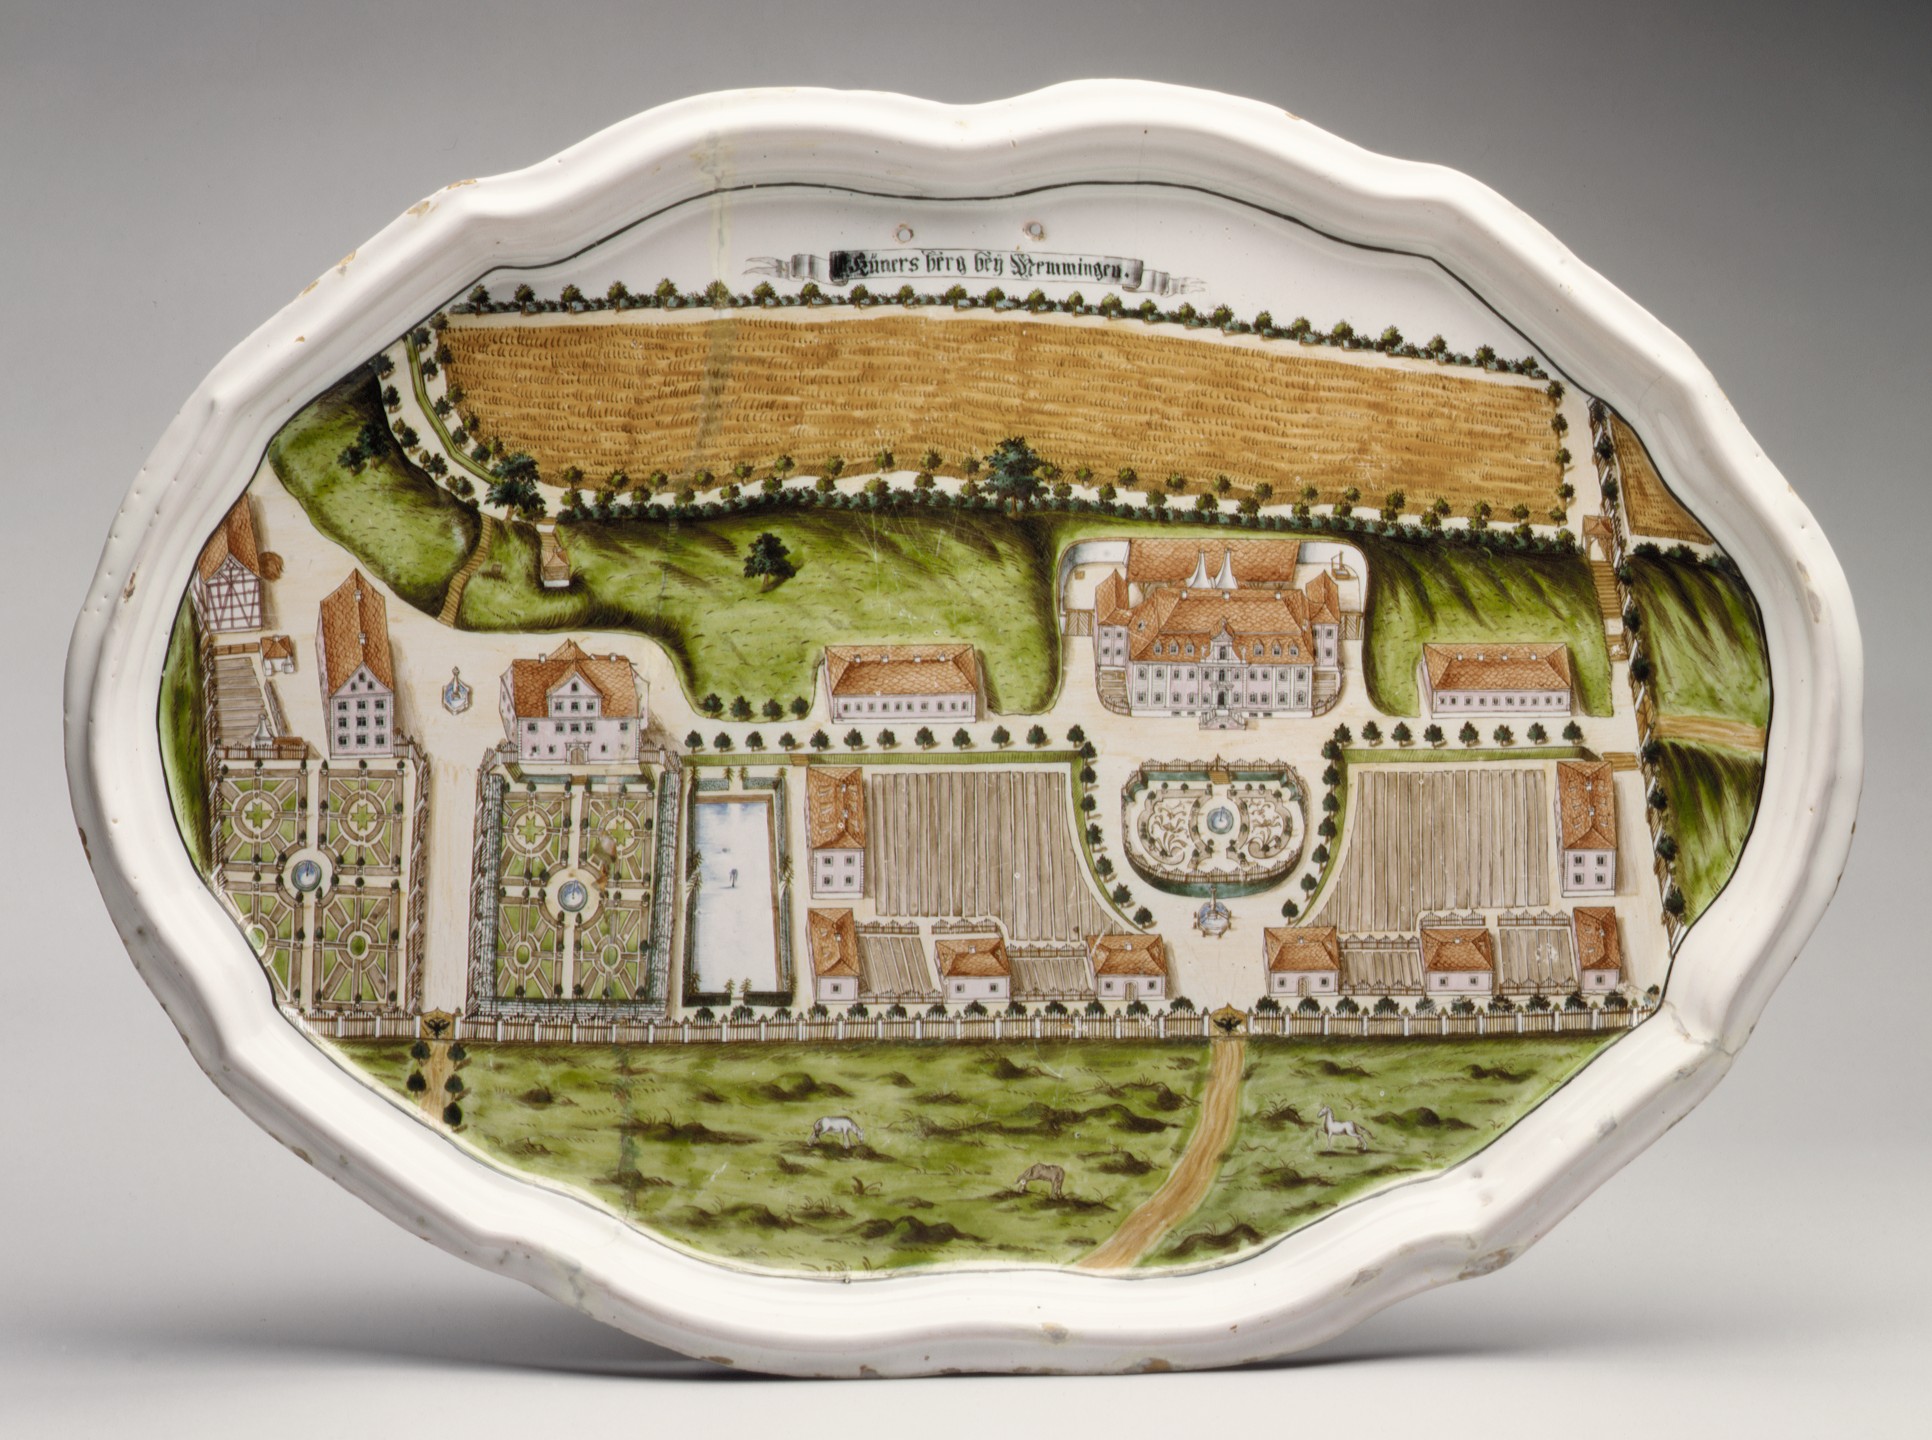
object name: plateau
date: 1760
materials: earthenware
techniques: glazing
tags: buildings